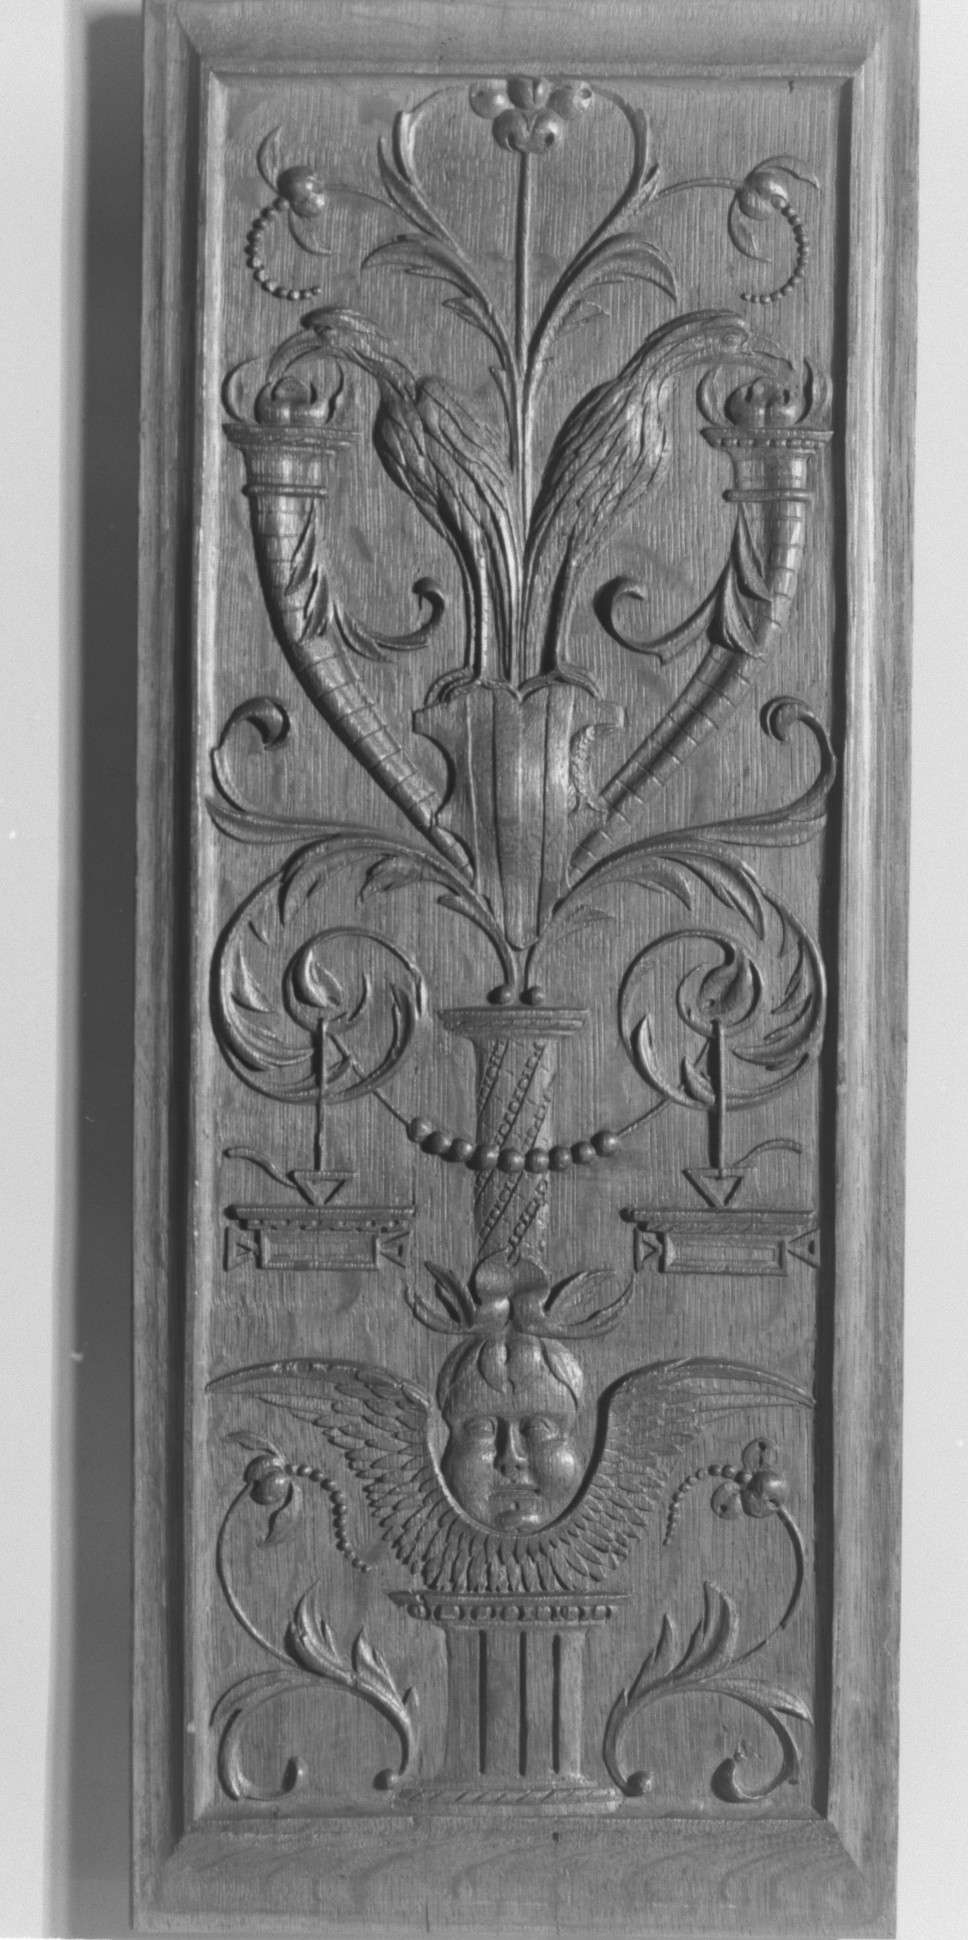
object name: panel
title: Panel (part of a set)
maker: nicolas castille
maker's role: maker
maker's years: 1503-1521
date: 1510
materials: wood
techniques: carving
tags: birds